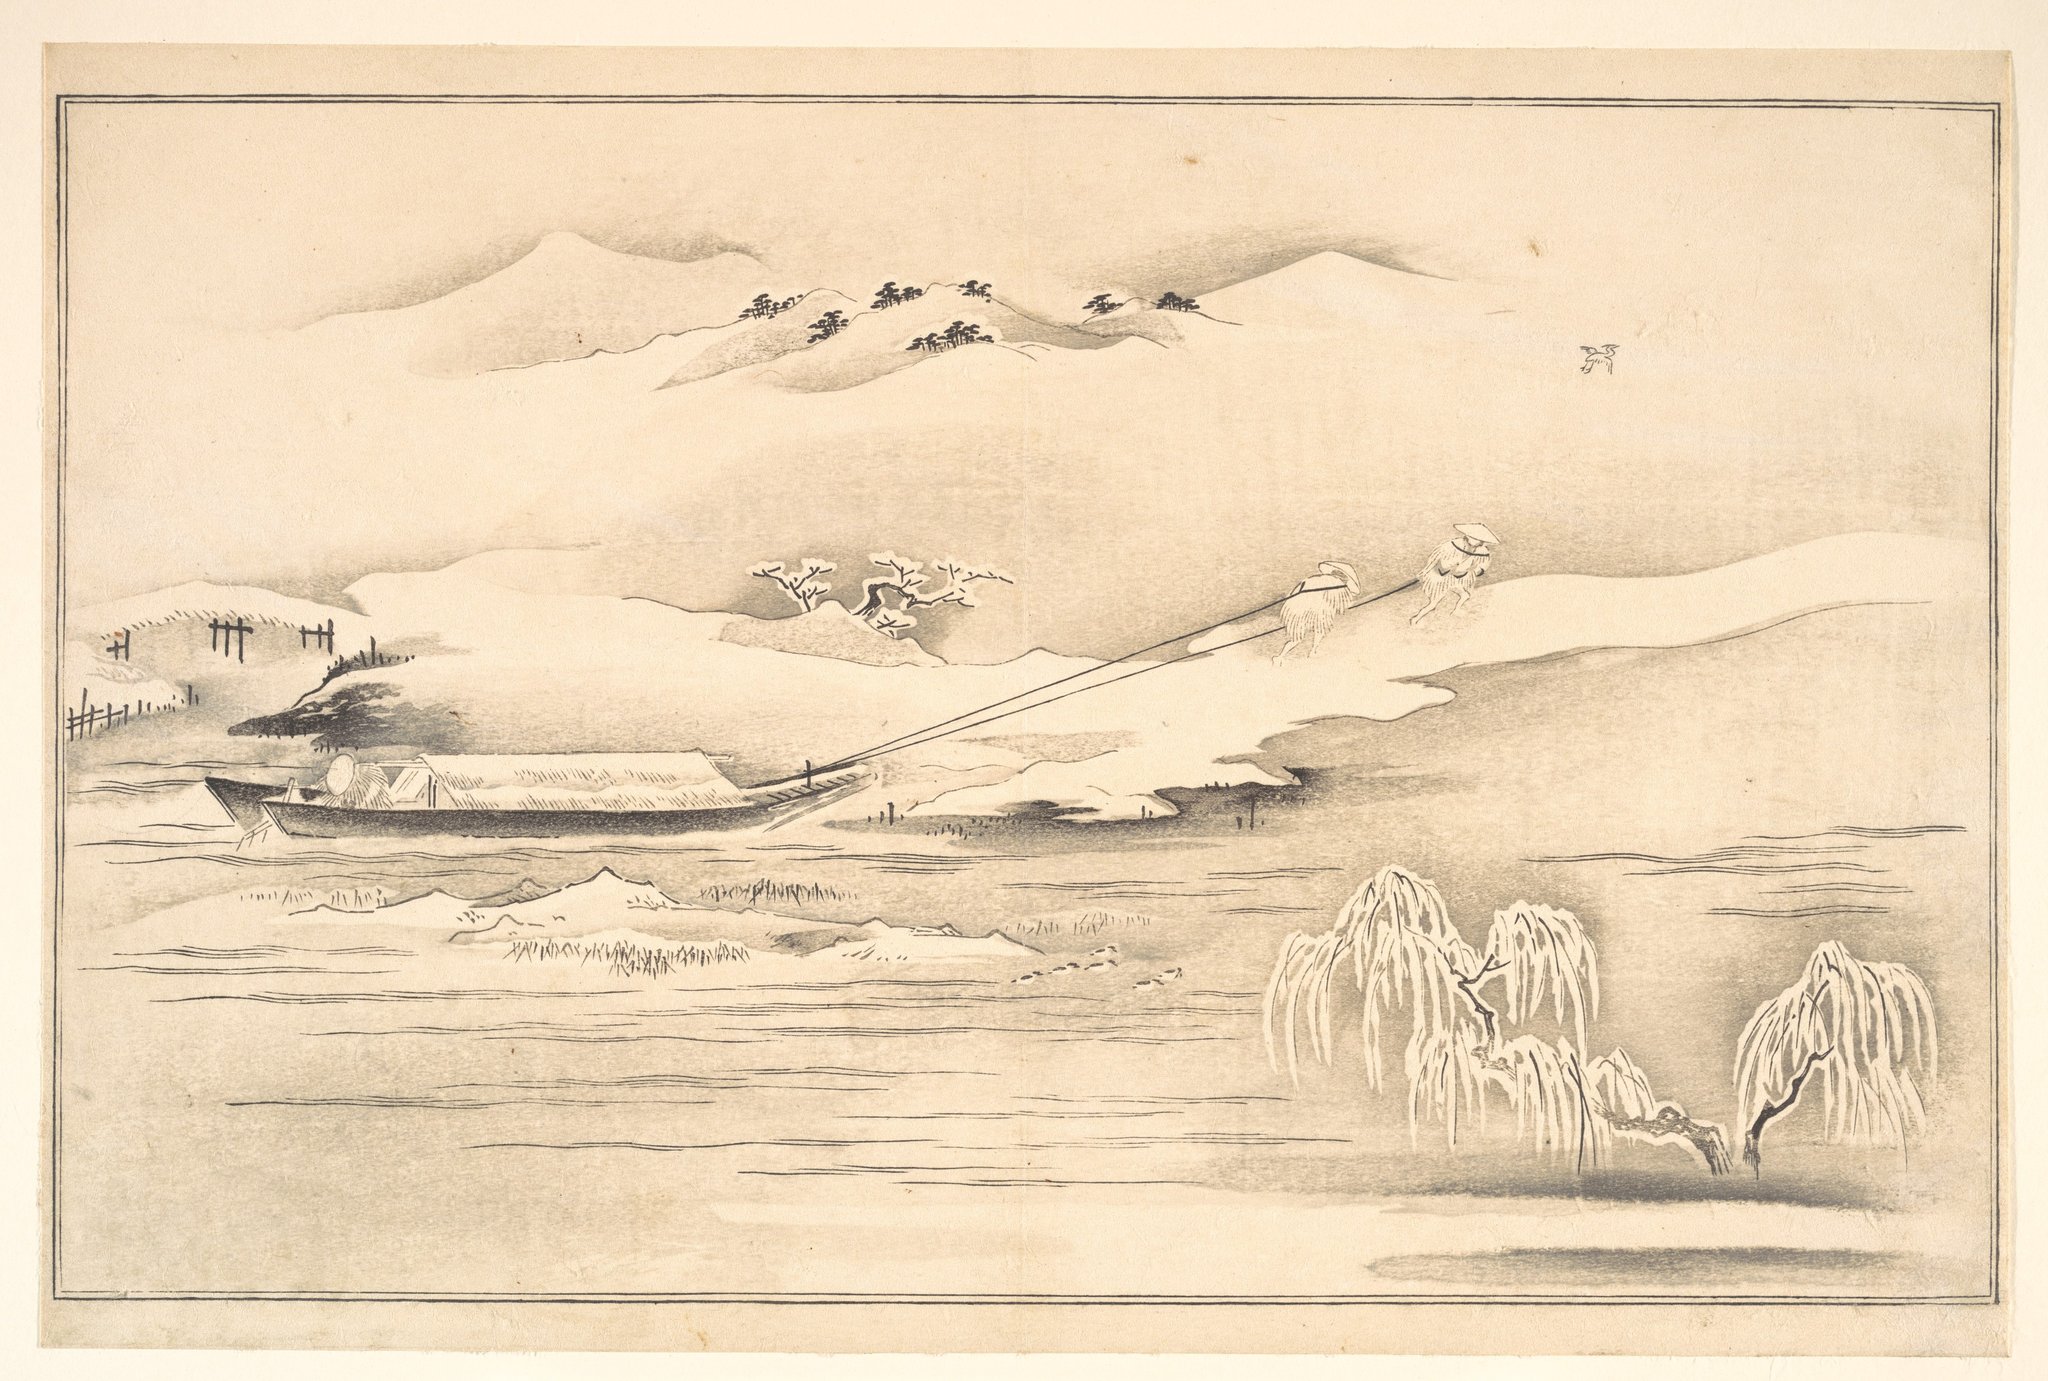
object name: woodblock print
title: Book of Ehon Ginsekai (The World in Silver)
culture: japanese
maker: kitagawa utamaro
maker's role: artist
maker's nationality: japanese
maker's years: 1754-1806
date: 1754-1806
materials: ink, paper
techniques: woodblock print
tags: rivers,landscapes,snow,boats